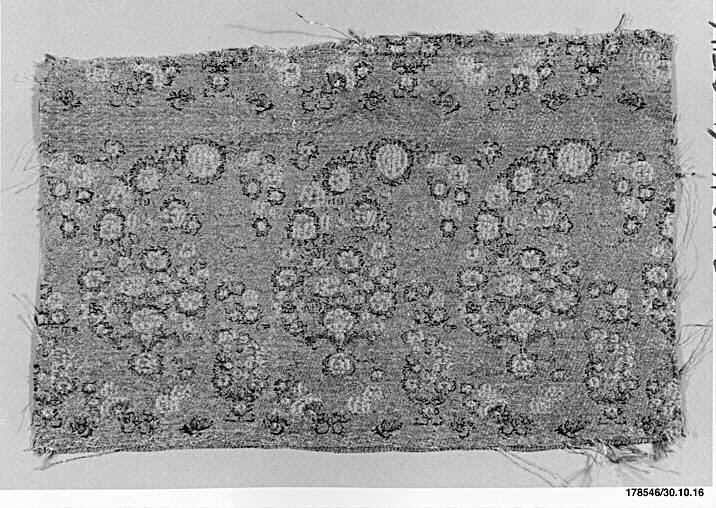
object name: textile fragment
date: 1501-1700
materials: metal thread, silk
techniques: brocade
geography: iran